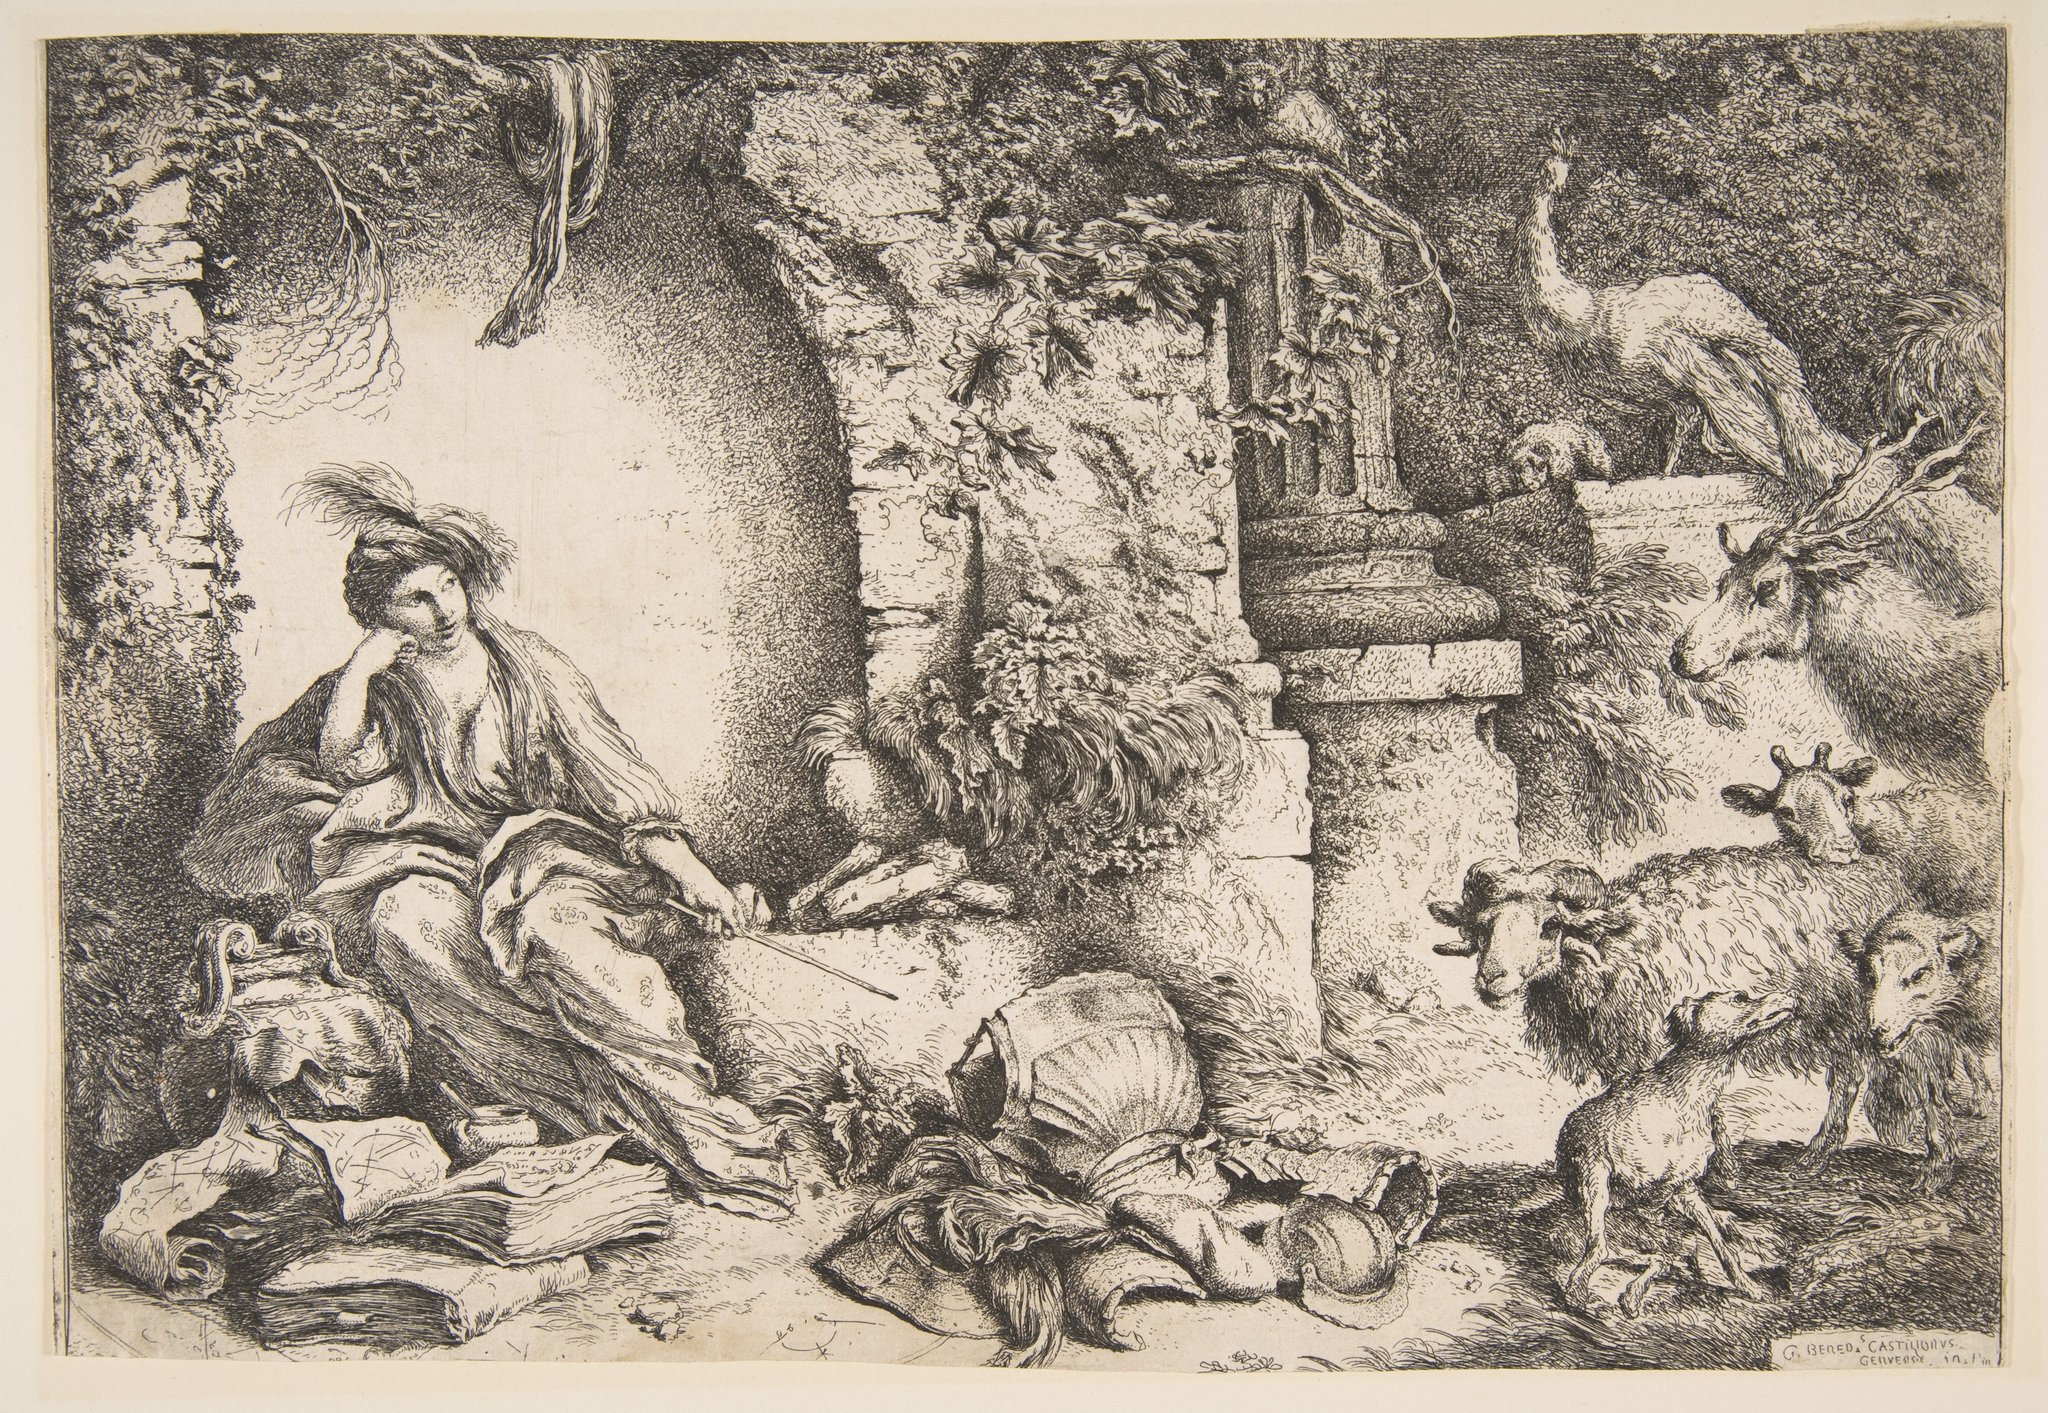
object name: print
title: Circe changing the companions of Ulysses into beasts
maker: giovanni benedetto castiglione (il grechetto)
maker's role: artist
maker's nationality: italian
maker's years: 1609-1664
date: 1650-1651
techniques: etching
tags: women,peacocks,deer,sheep